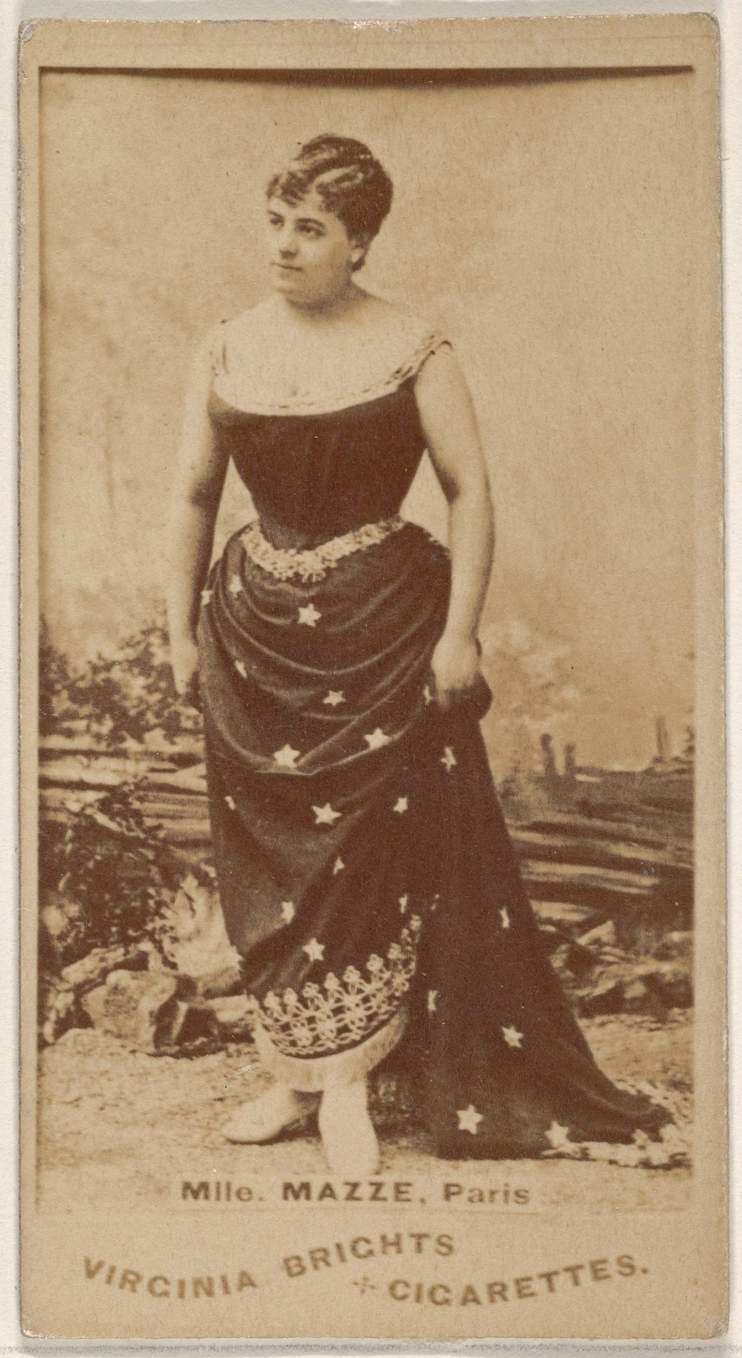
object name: photograph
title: Mlle. Mazze, Paris, from the Actors and Actresses series (N45, Type 1) for Virginia Brights Cigarettes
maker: allen & ginter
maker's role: publisher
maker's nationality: american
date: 1888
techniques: albumen silver print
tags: portraits,women,actresses